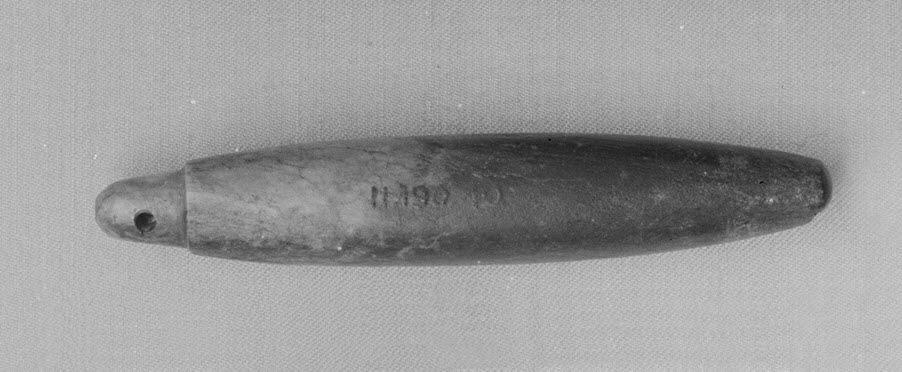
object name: pendant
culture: chinese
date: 3200-2000 BCE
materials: jade